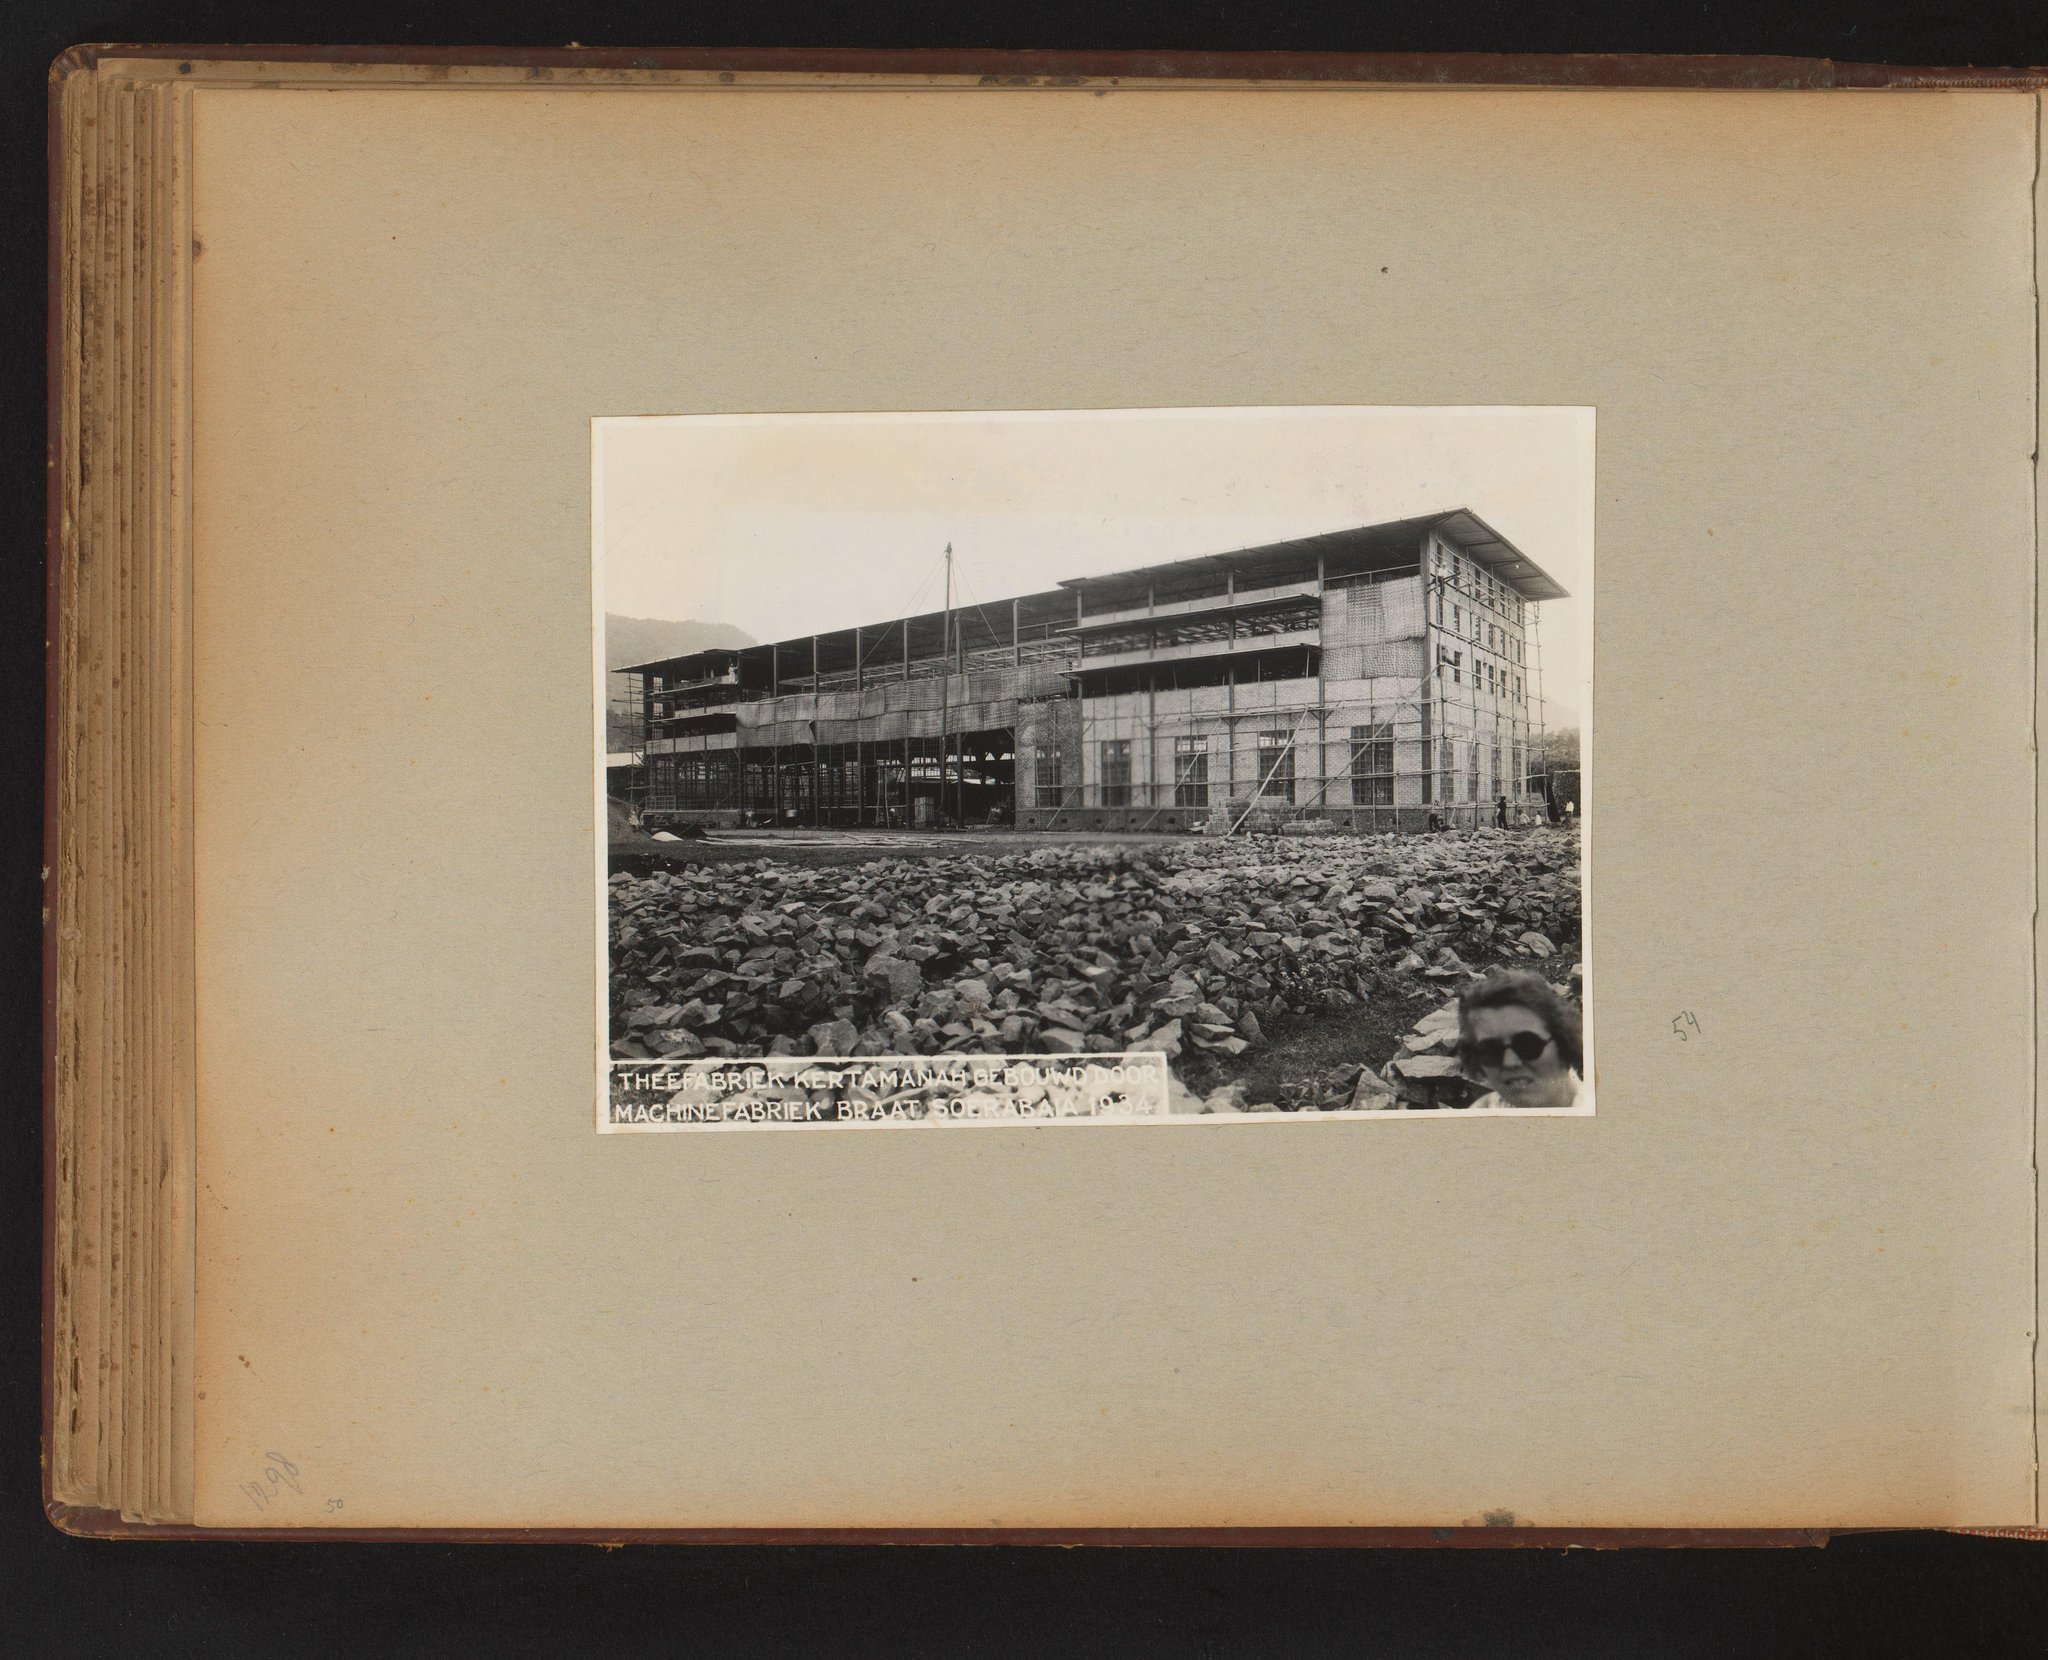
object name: photograph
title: Theefabriek Kertamanah gebouwd door Machinefabriek Braat Soerabaia 1934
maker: Anonymous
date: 1934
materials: cardboard, photographic support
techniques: gelatin silver print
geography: bandung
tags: factory-building, making the overground structures (~ building activities), java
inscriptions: date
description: Albumblad met een foto van de theefabriek Kertamanah ten zuiden van Bandoeng, in aanbouw in 1934. Onderdeel van een fotoalbum met foto's van machines en constructies van de N.V. Machinefabriek Braat te Soerabaja, Soekaboemi en Tegal uit de periode 1931-1937.